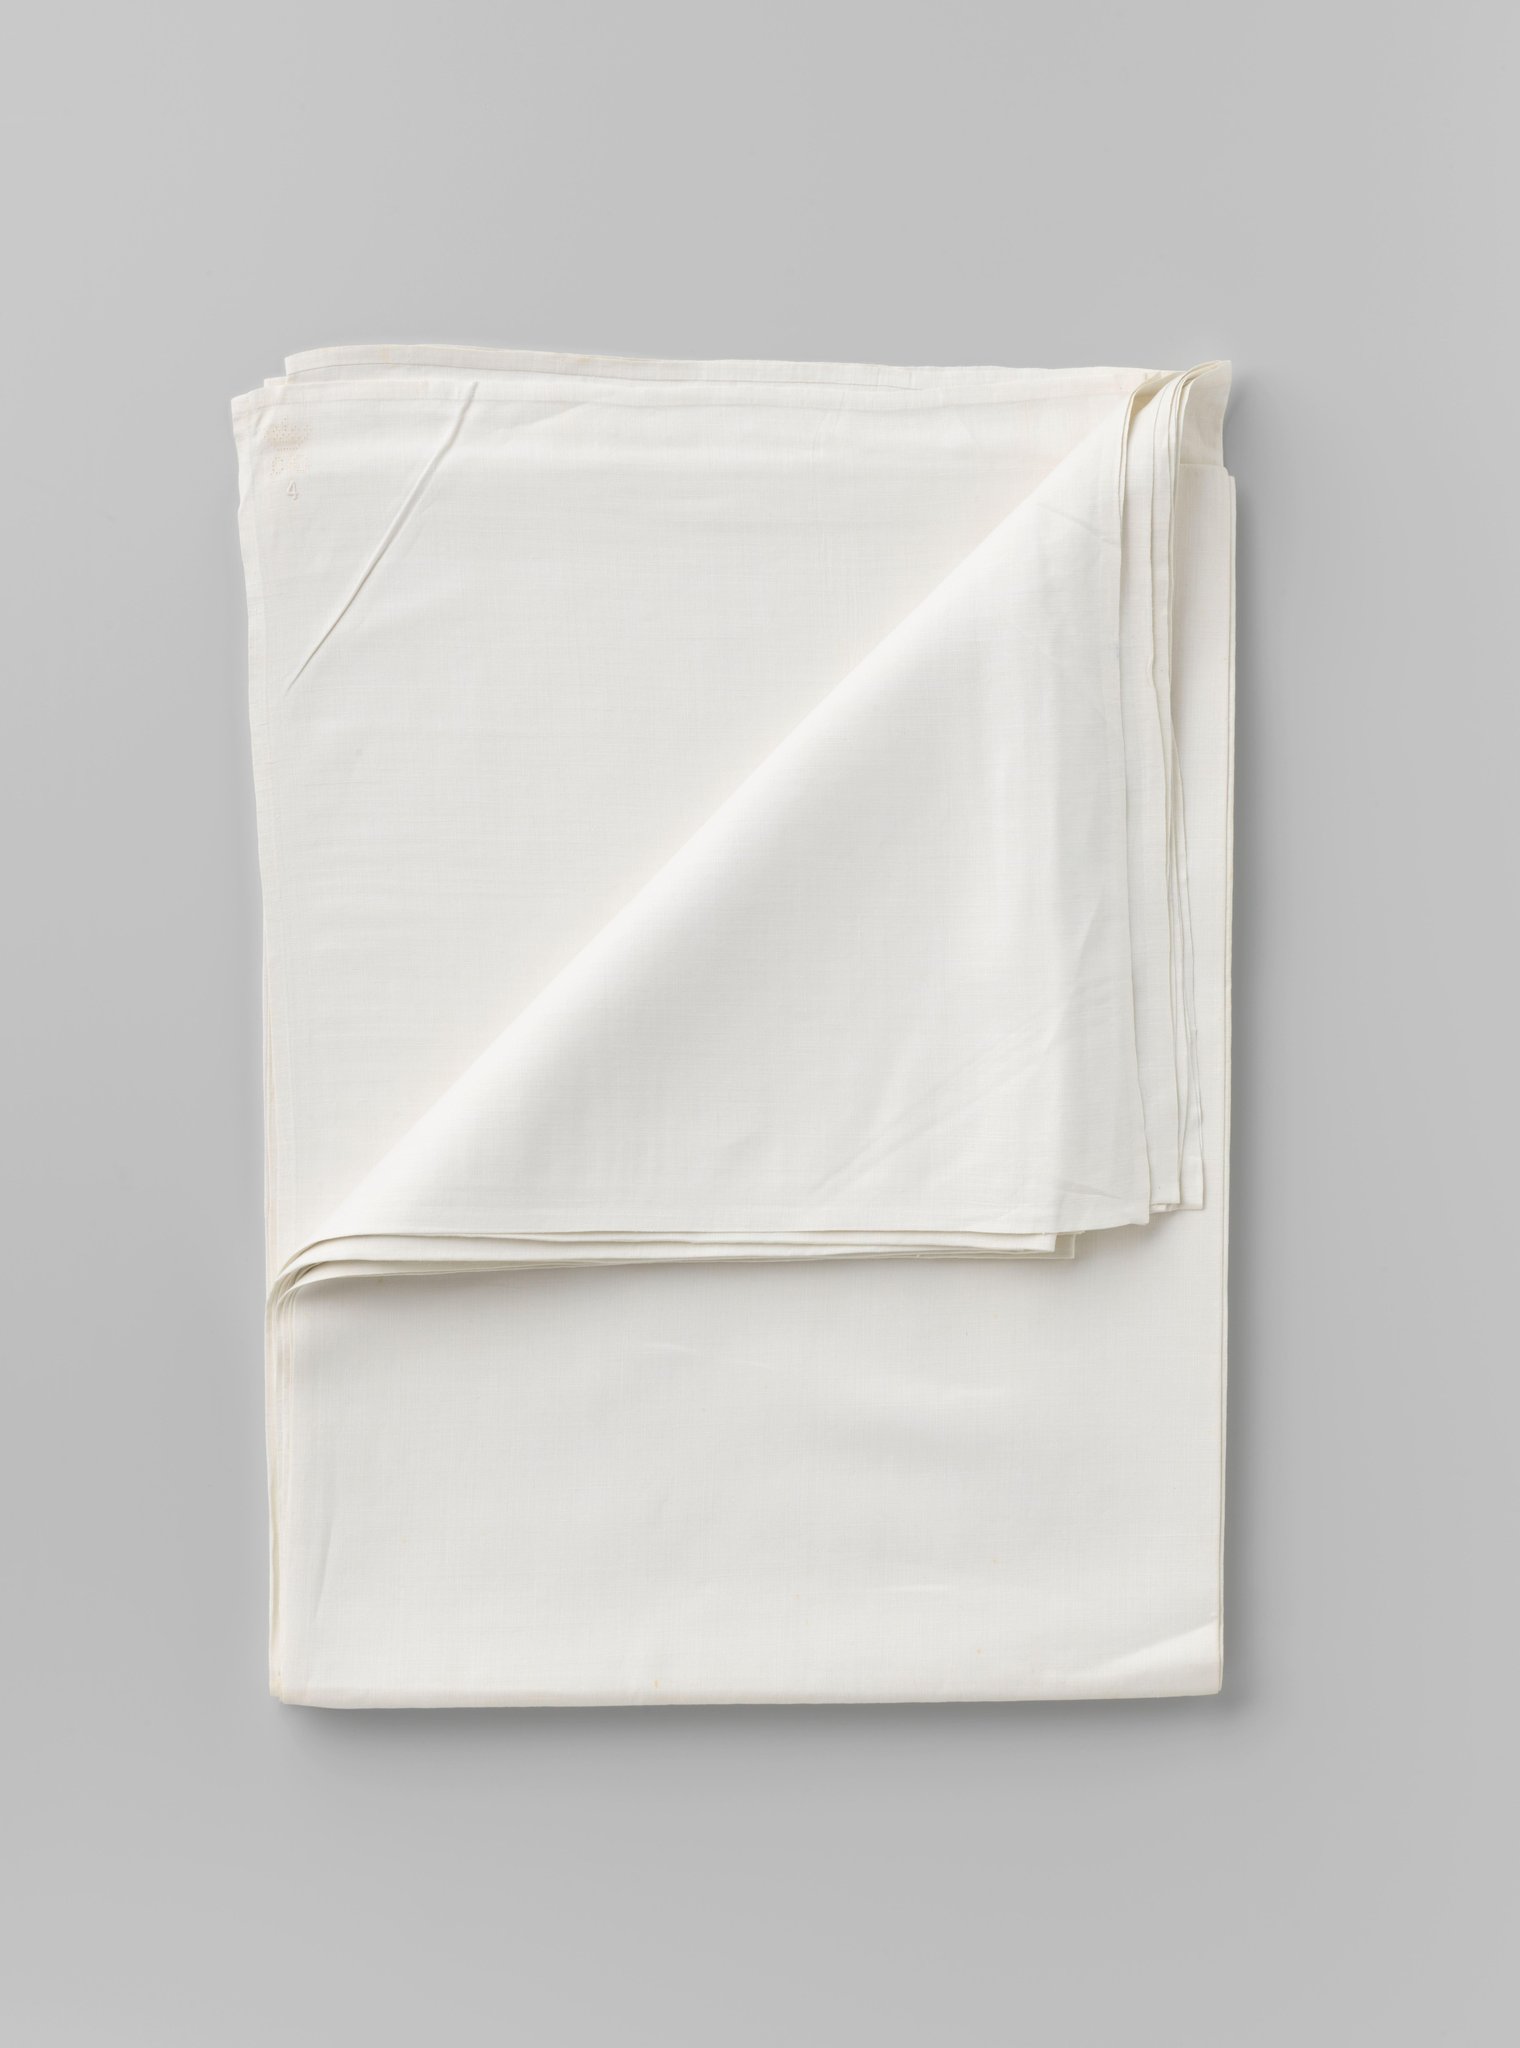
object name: beddenlaken, laken object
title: Laken. Merk: kroon EC 4.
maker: Anonymous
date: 1640-1660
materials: linen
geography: northern netherlands